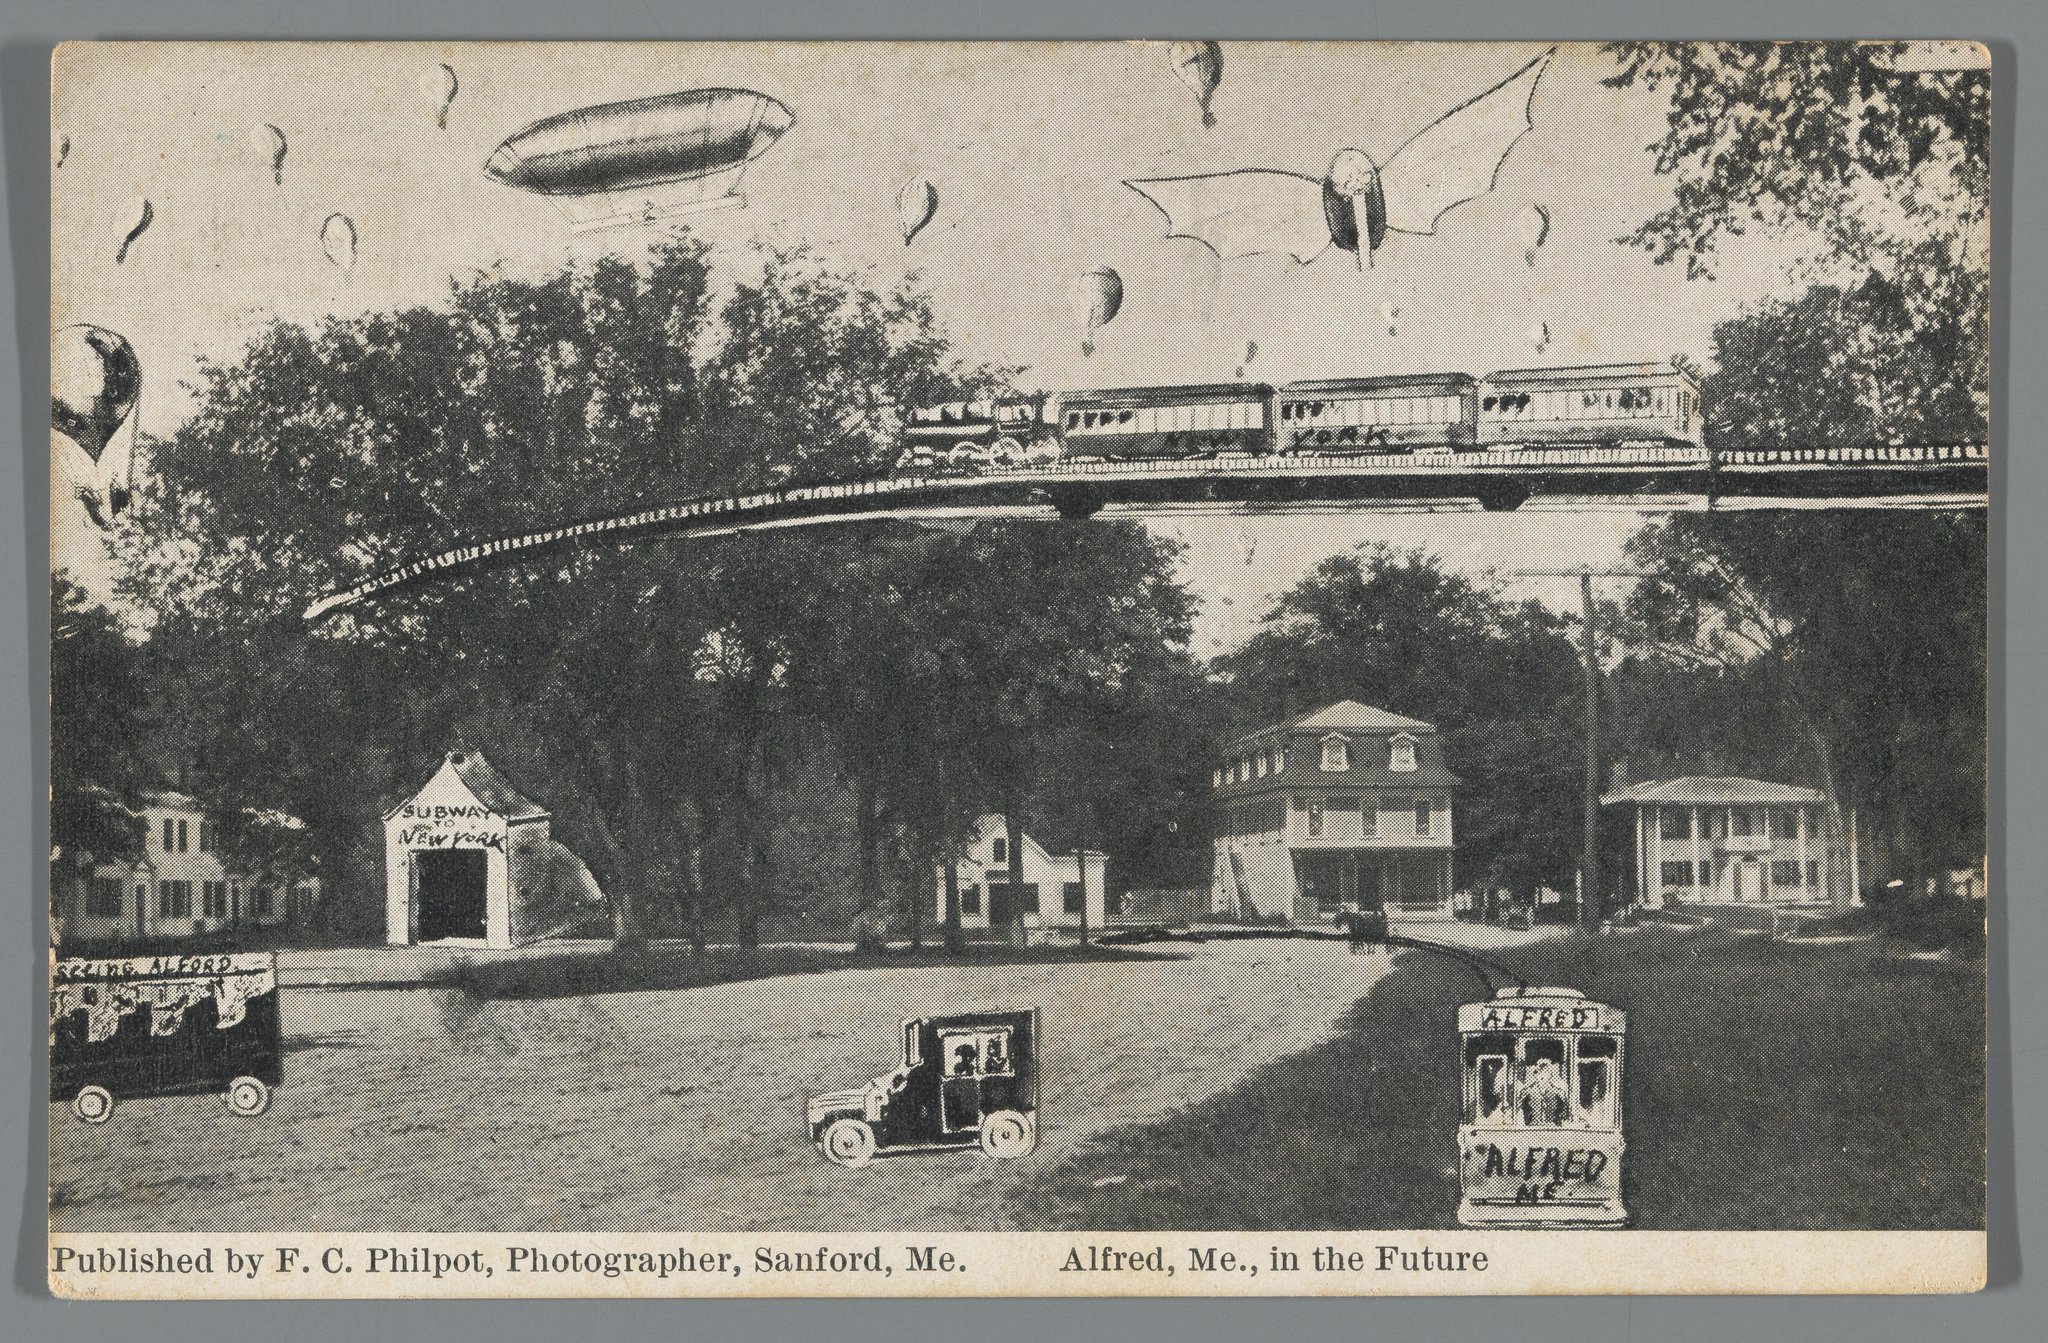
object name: ansichtkaart, prentbriefkaart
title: City of the Future (Alfred, ME)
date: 1910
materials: cardboard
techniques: collage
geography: united states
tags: alfred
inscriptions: inscription: ‘Published by F.C. Philpot, Sanford, Me. / Alfred, Me., in the Future.’